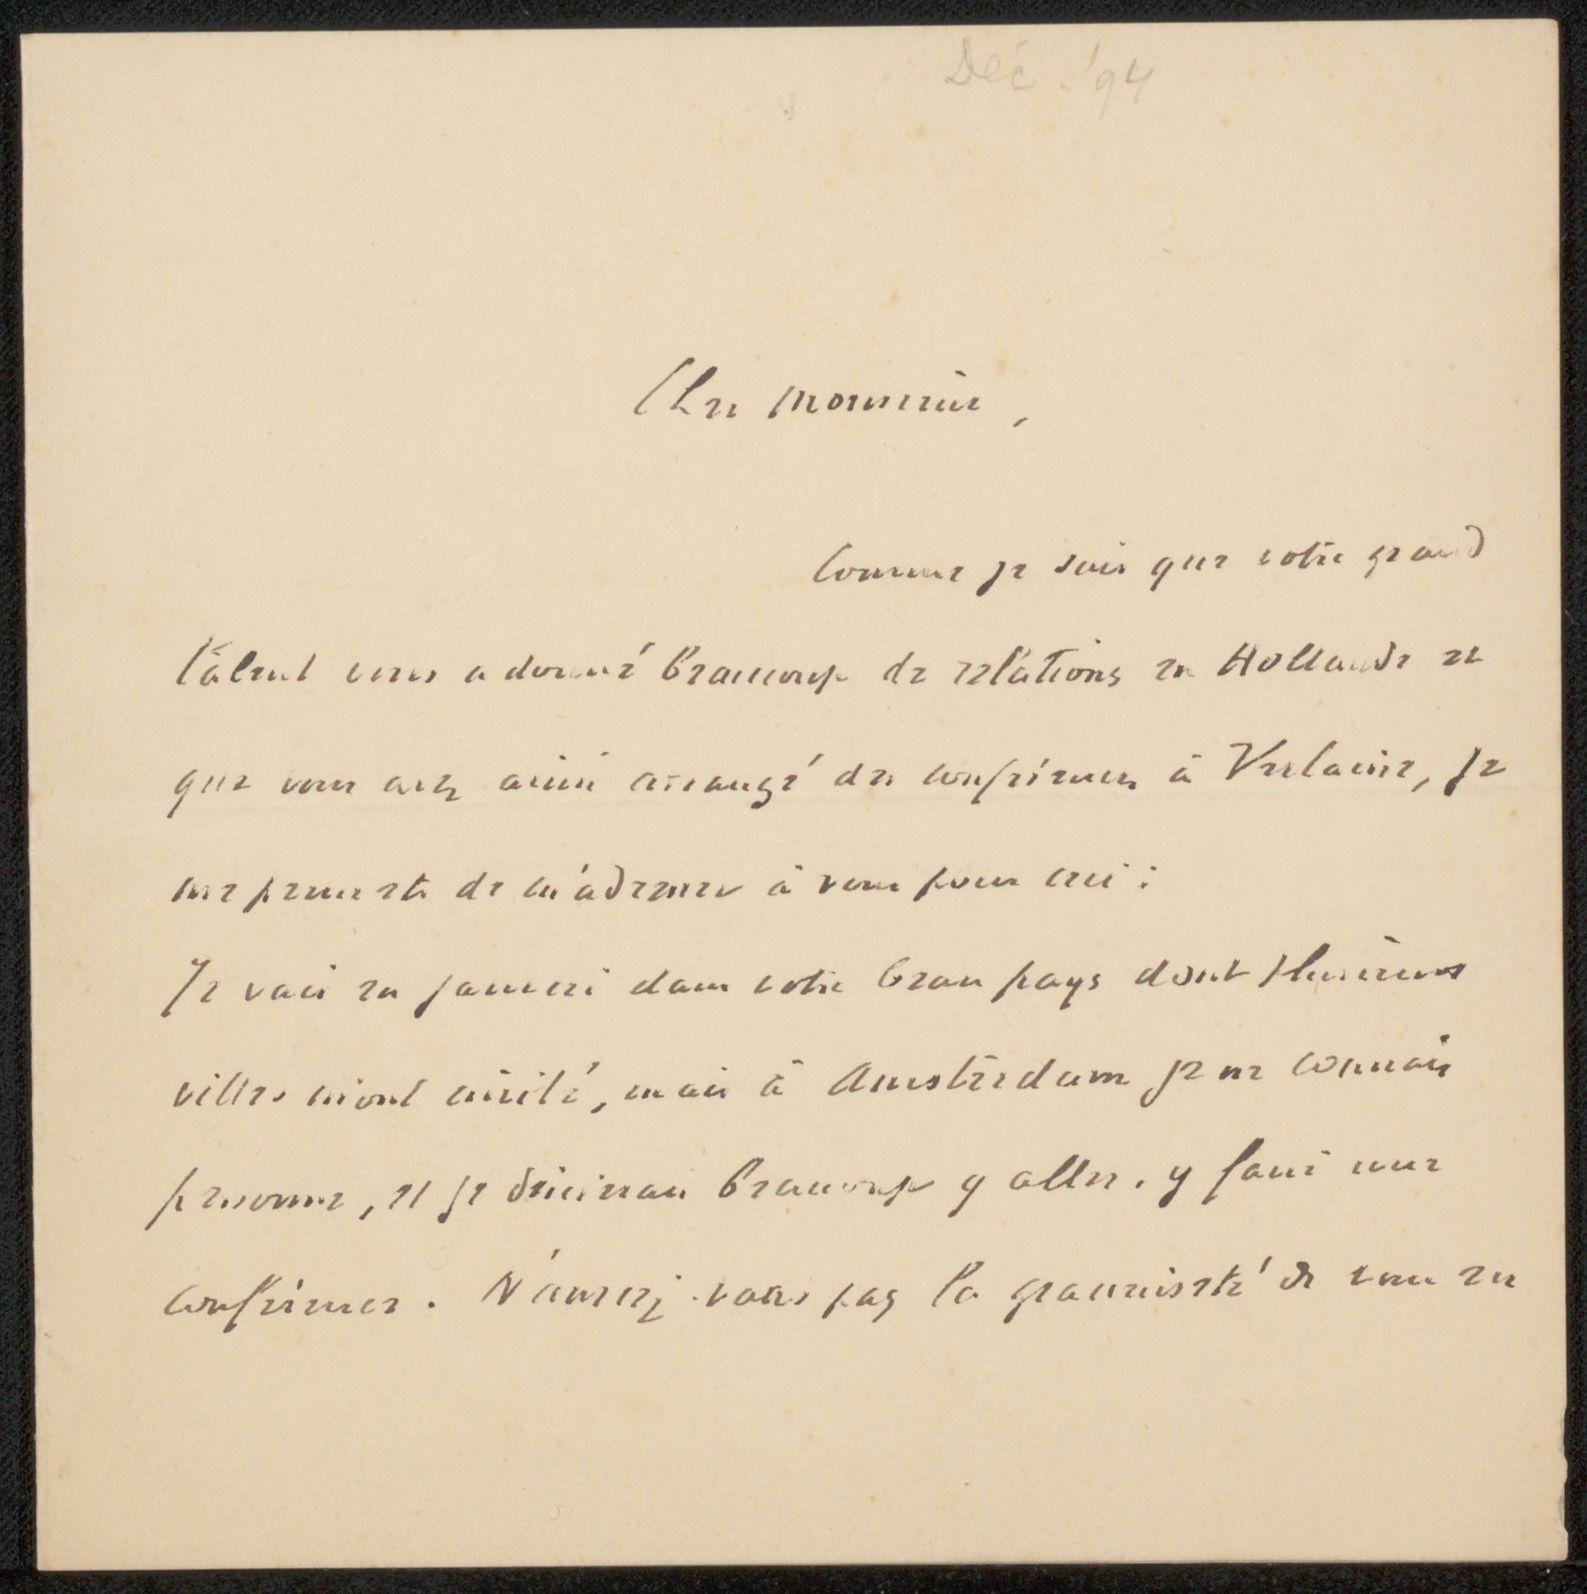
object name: letter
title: Brief aan Philip Zilcken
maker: georges rodenbach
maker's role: dichter, schrijver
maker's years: 1855-1898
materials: ink, paper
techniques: pen, writing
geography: paris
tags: paris, paul verlaine, painter, draughtsman, philip zilcken, the arts of the stage: ballet, theatre, musical drama, motion picture, netherlands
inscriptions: collector's mark: ‘RPK’